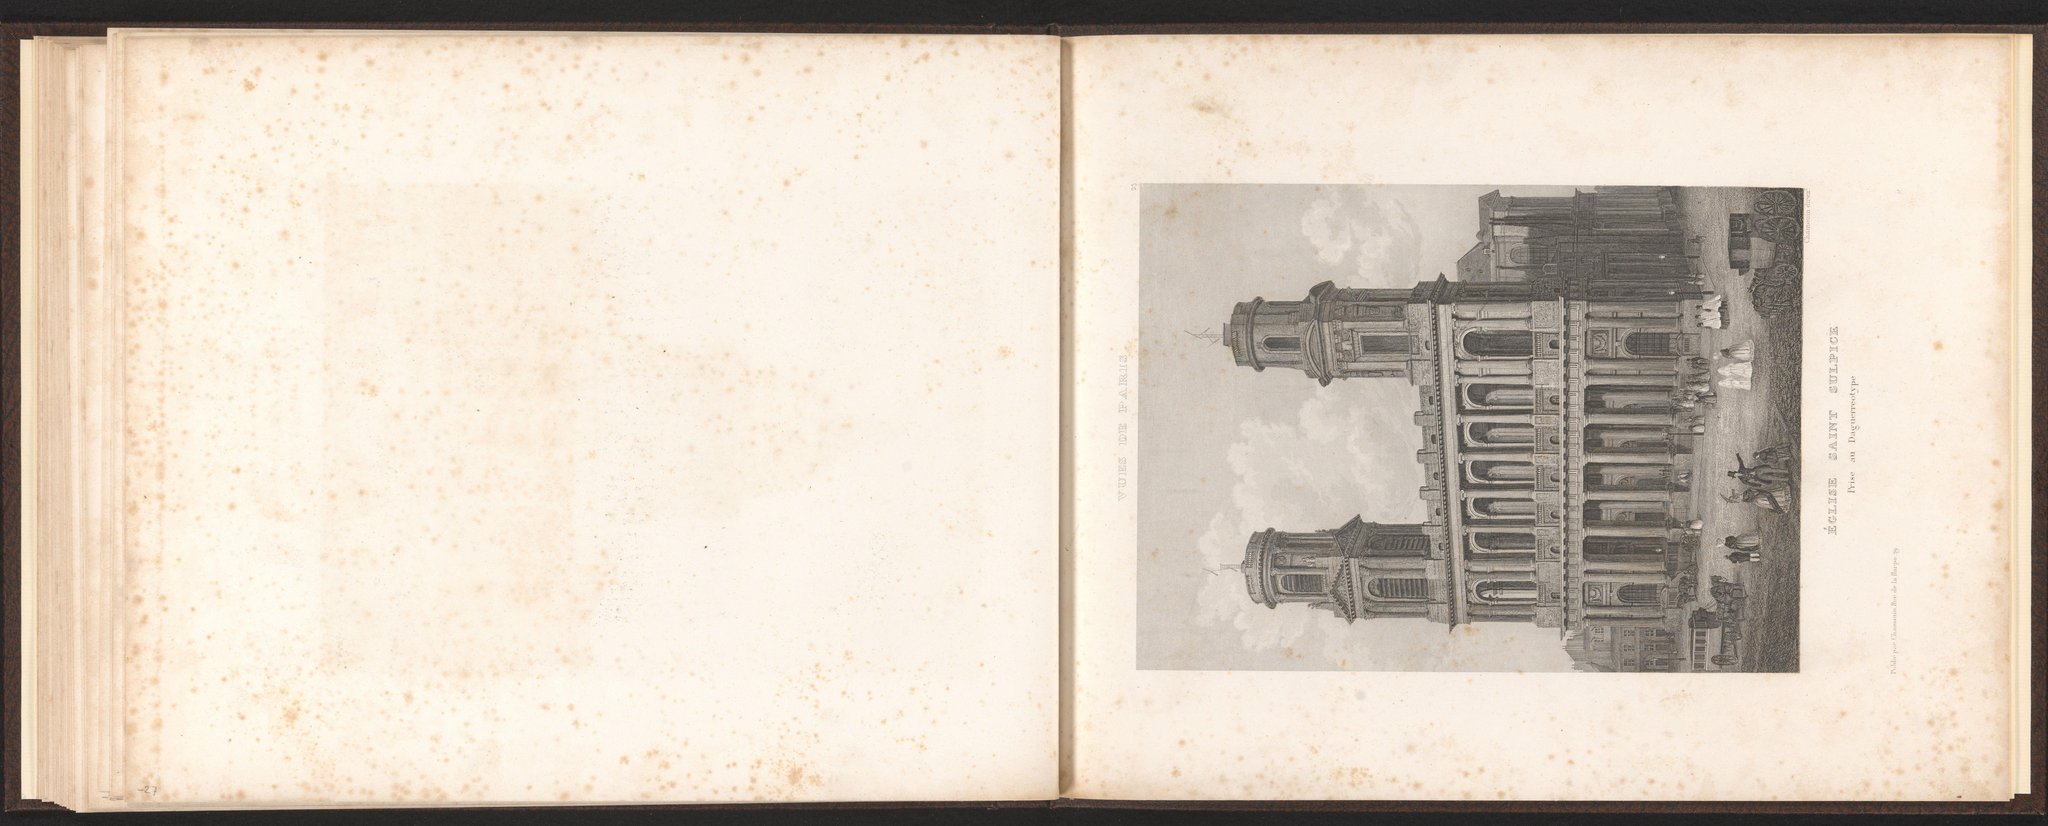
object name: page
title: Gezicht op de Église Saint-Sulpice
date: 1845-1850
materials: paper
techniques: engraving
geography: paris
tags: church (exterior)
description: Prent op achtentwintigste ongenummerde pagina na titelpagina. Prent gemaakt naar daguerreotypie.